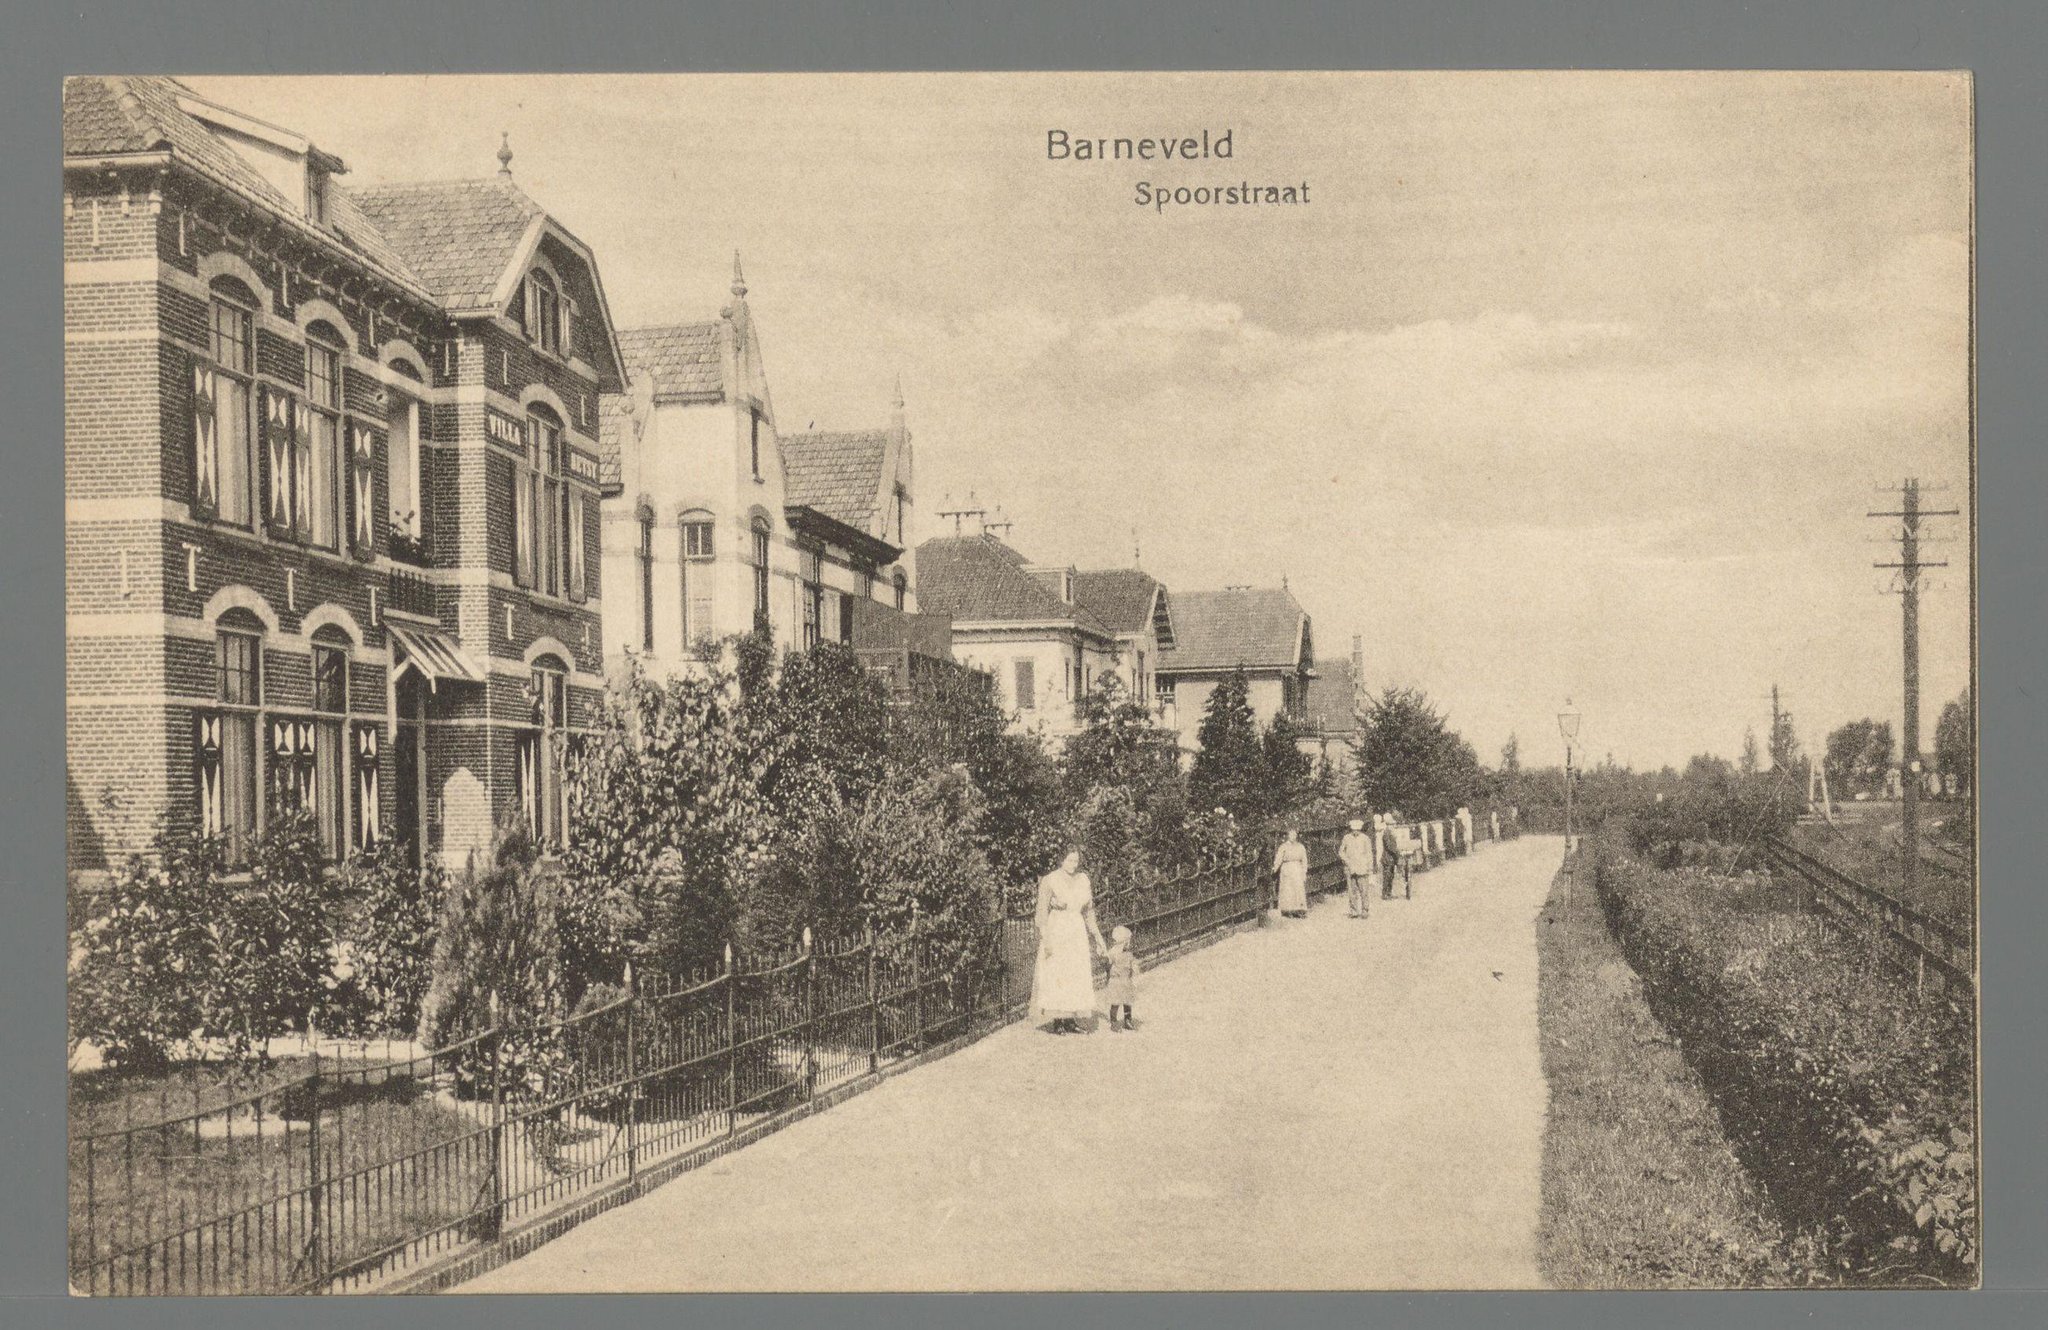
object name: photomechanical print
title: Barneveld. Spoorstraat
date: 1918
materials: cardboard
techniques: photograph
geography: barneveld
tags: railway, train, street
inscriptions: date